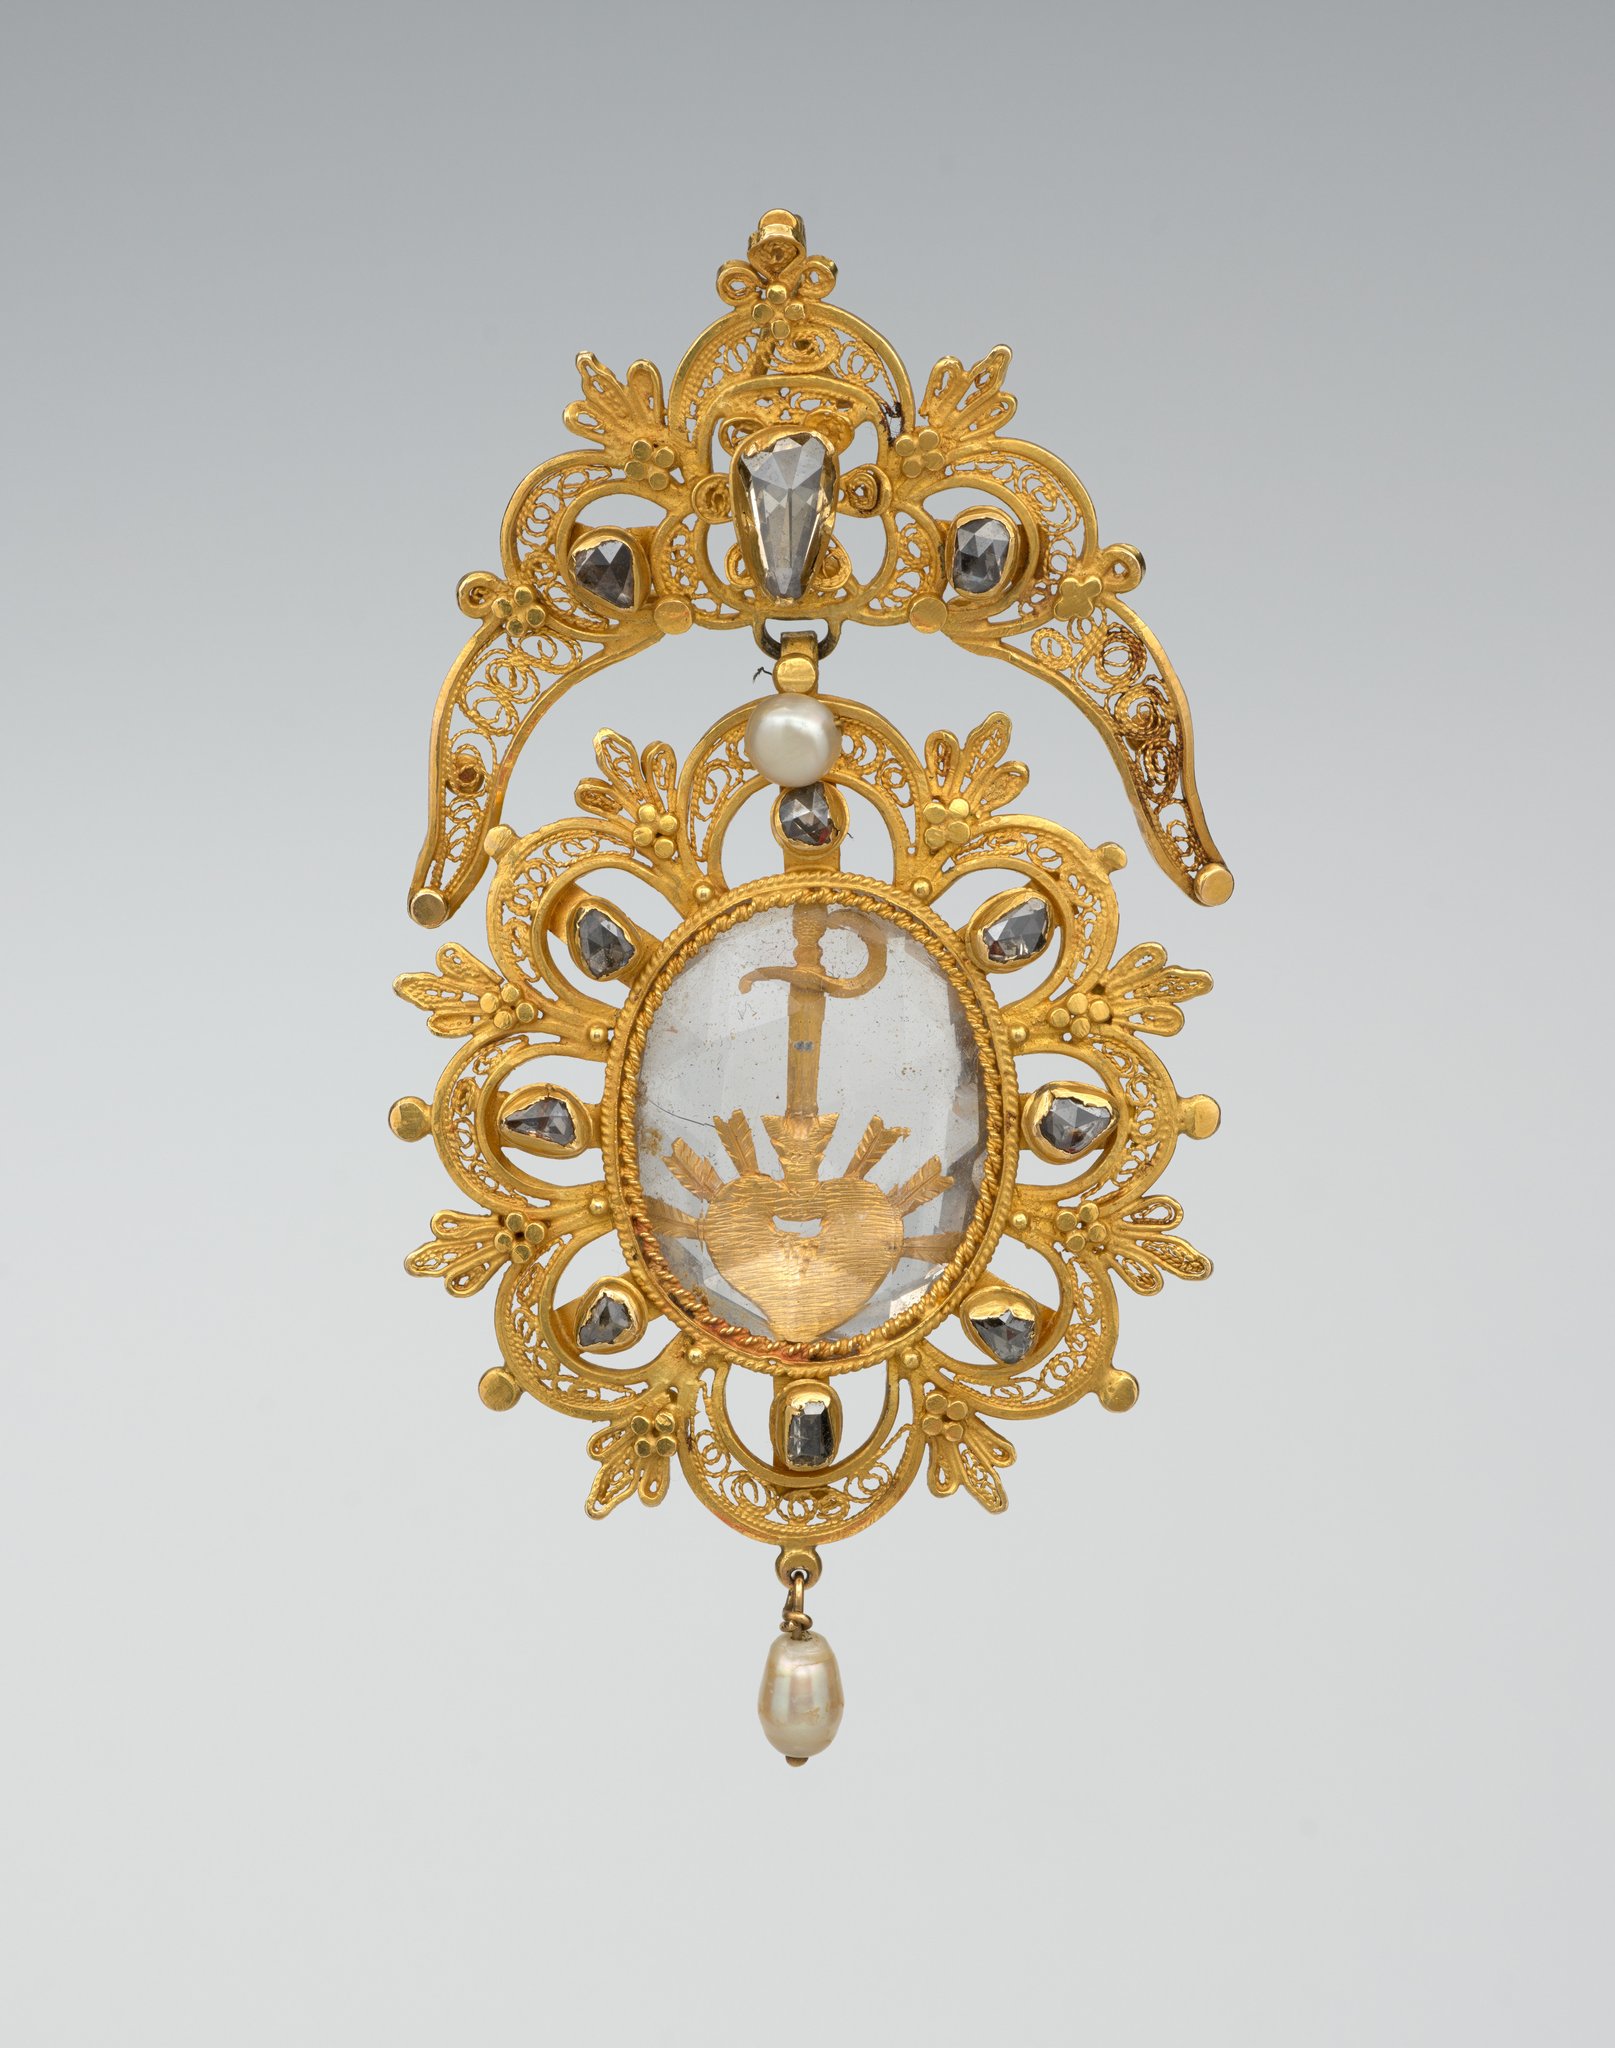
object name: chain, two pendant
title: Pendant with chain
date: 1701-1800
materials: diamond, gold, pearl